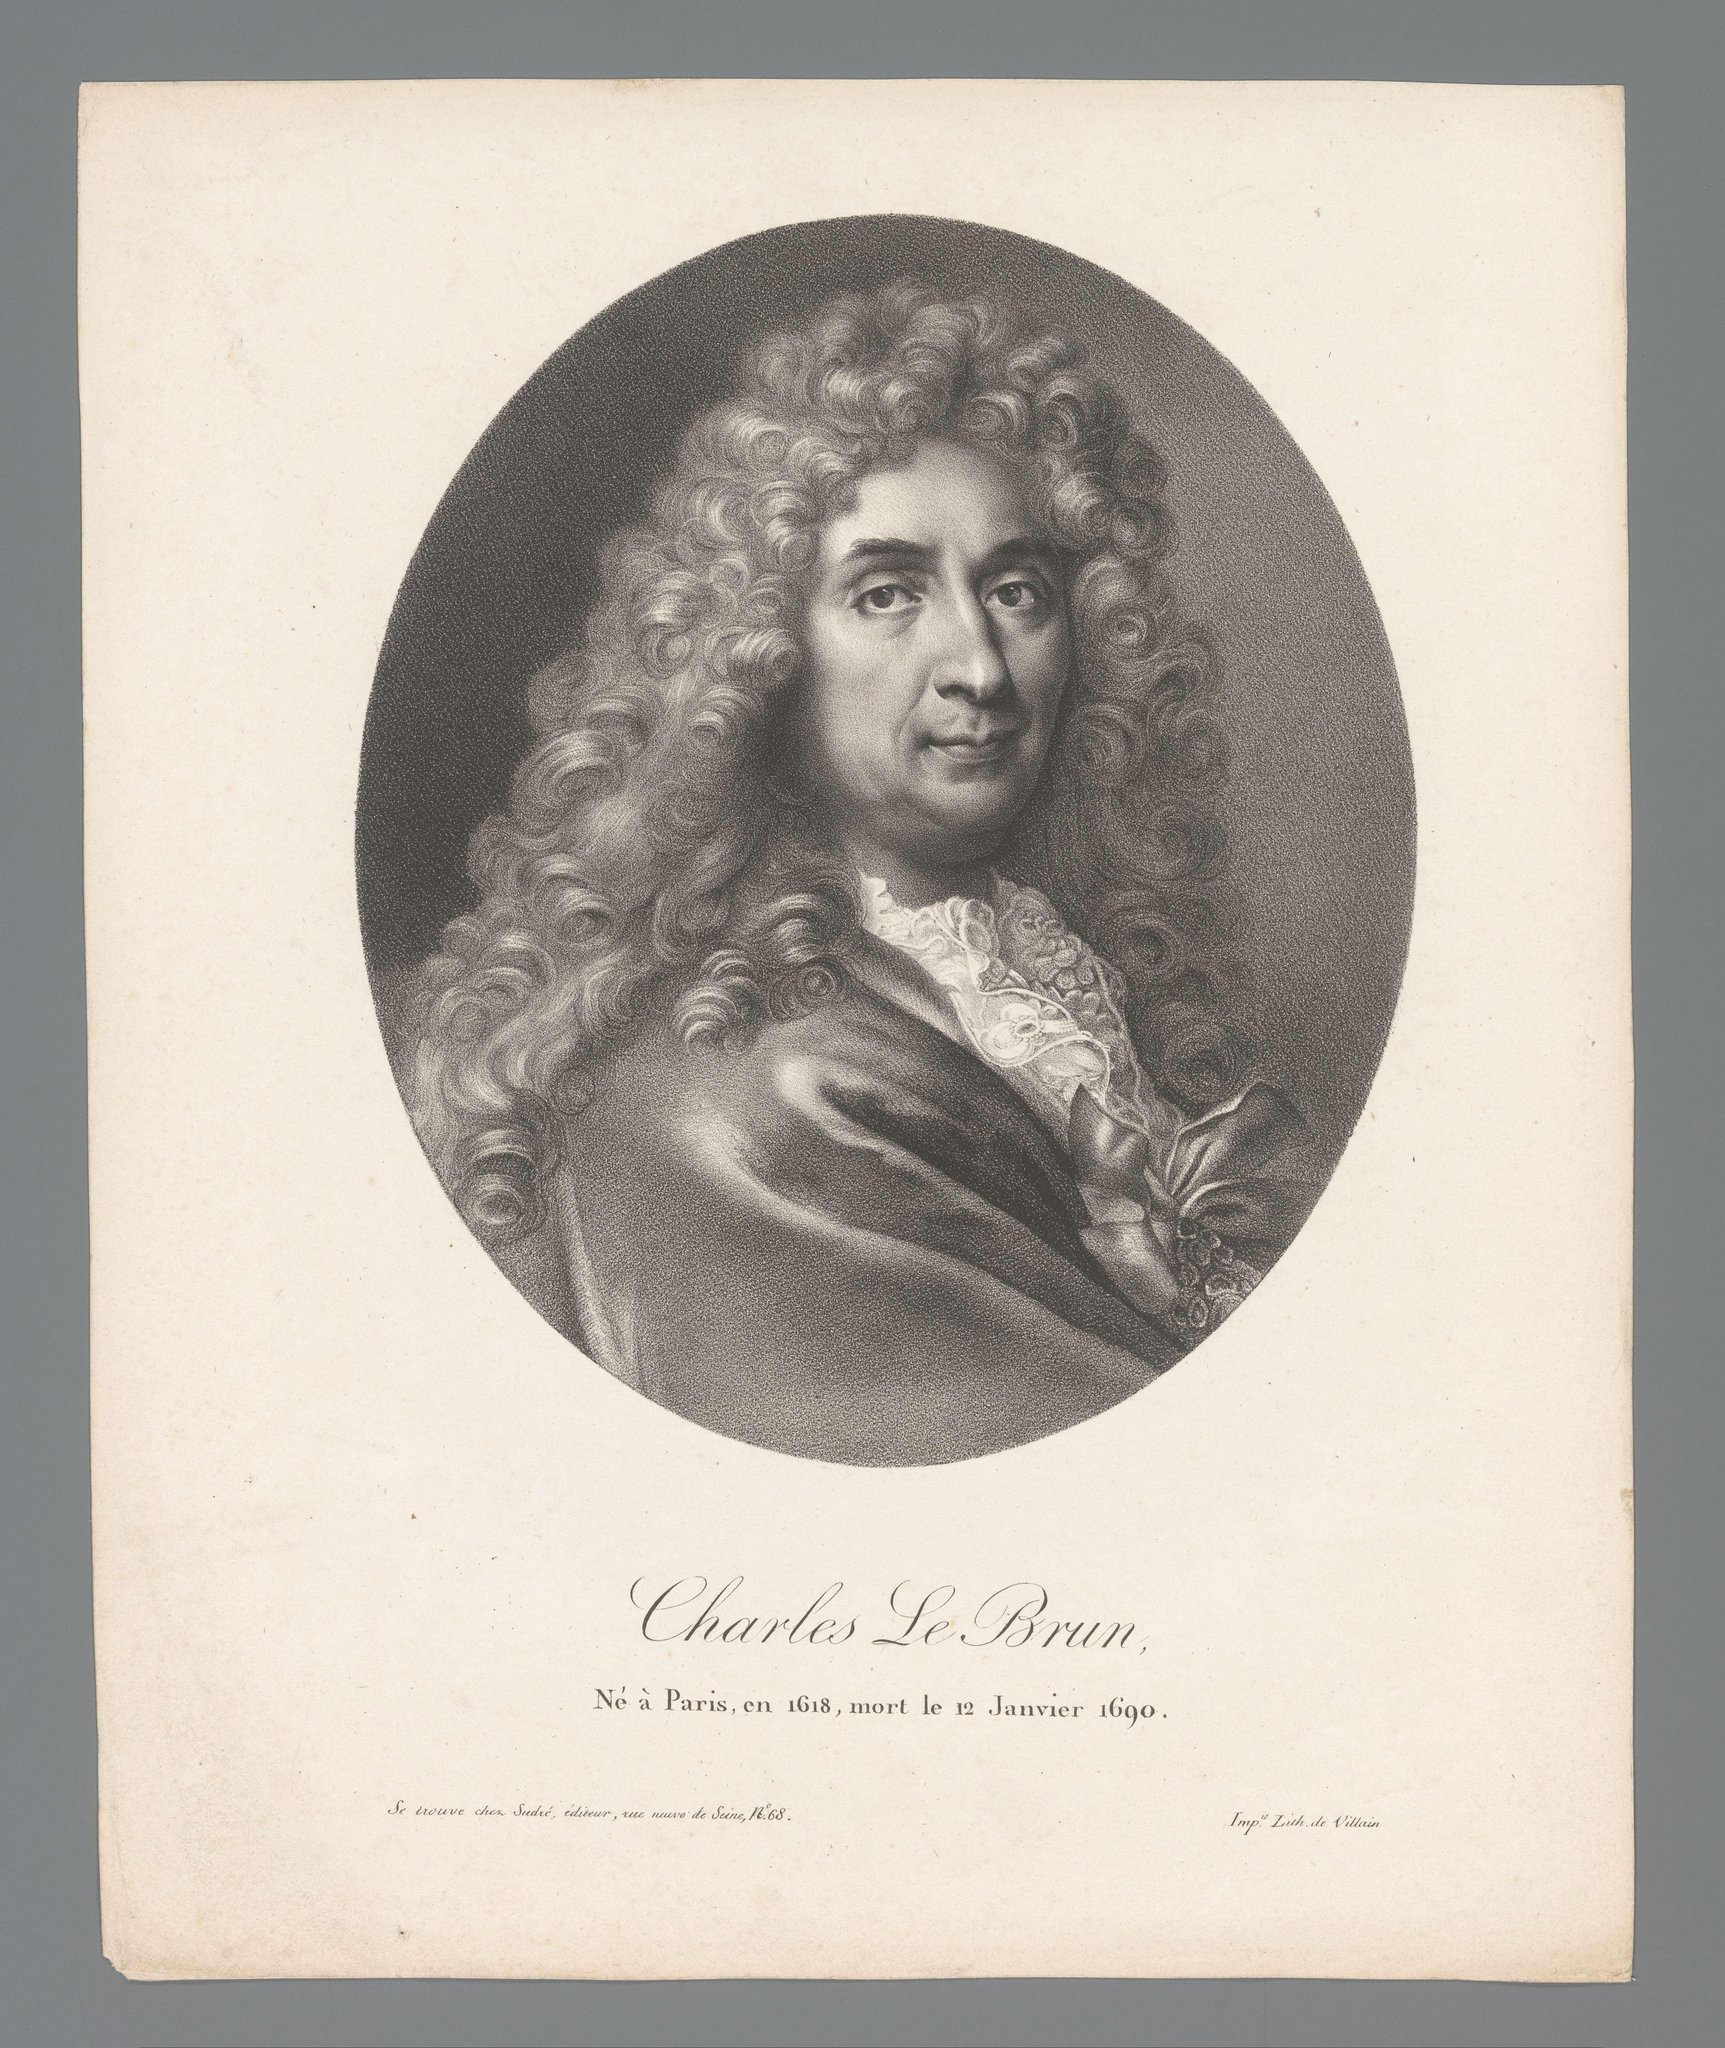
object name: print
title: Portret van Charles Le Brun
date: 1818-1852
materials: paper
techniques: lithograph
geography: paris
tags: paris, print maker, draughtsman, charles le brun, historical persons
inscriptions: collector's mark: Lugt 2228